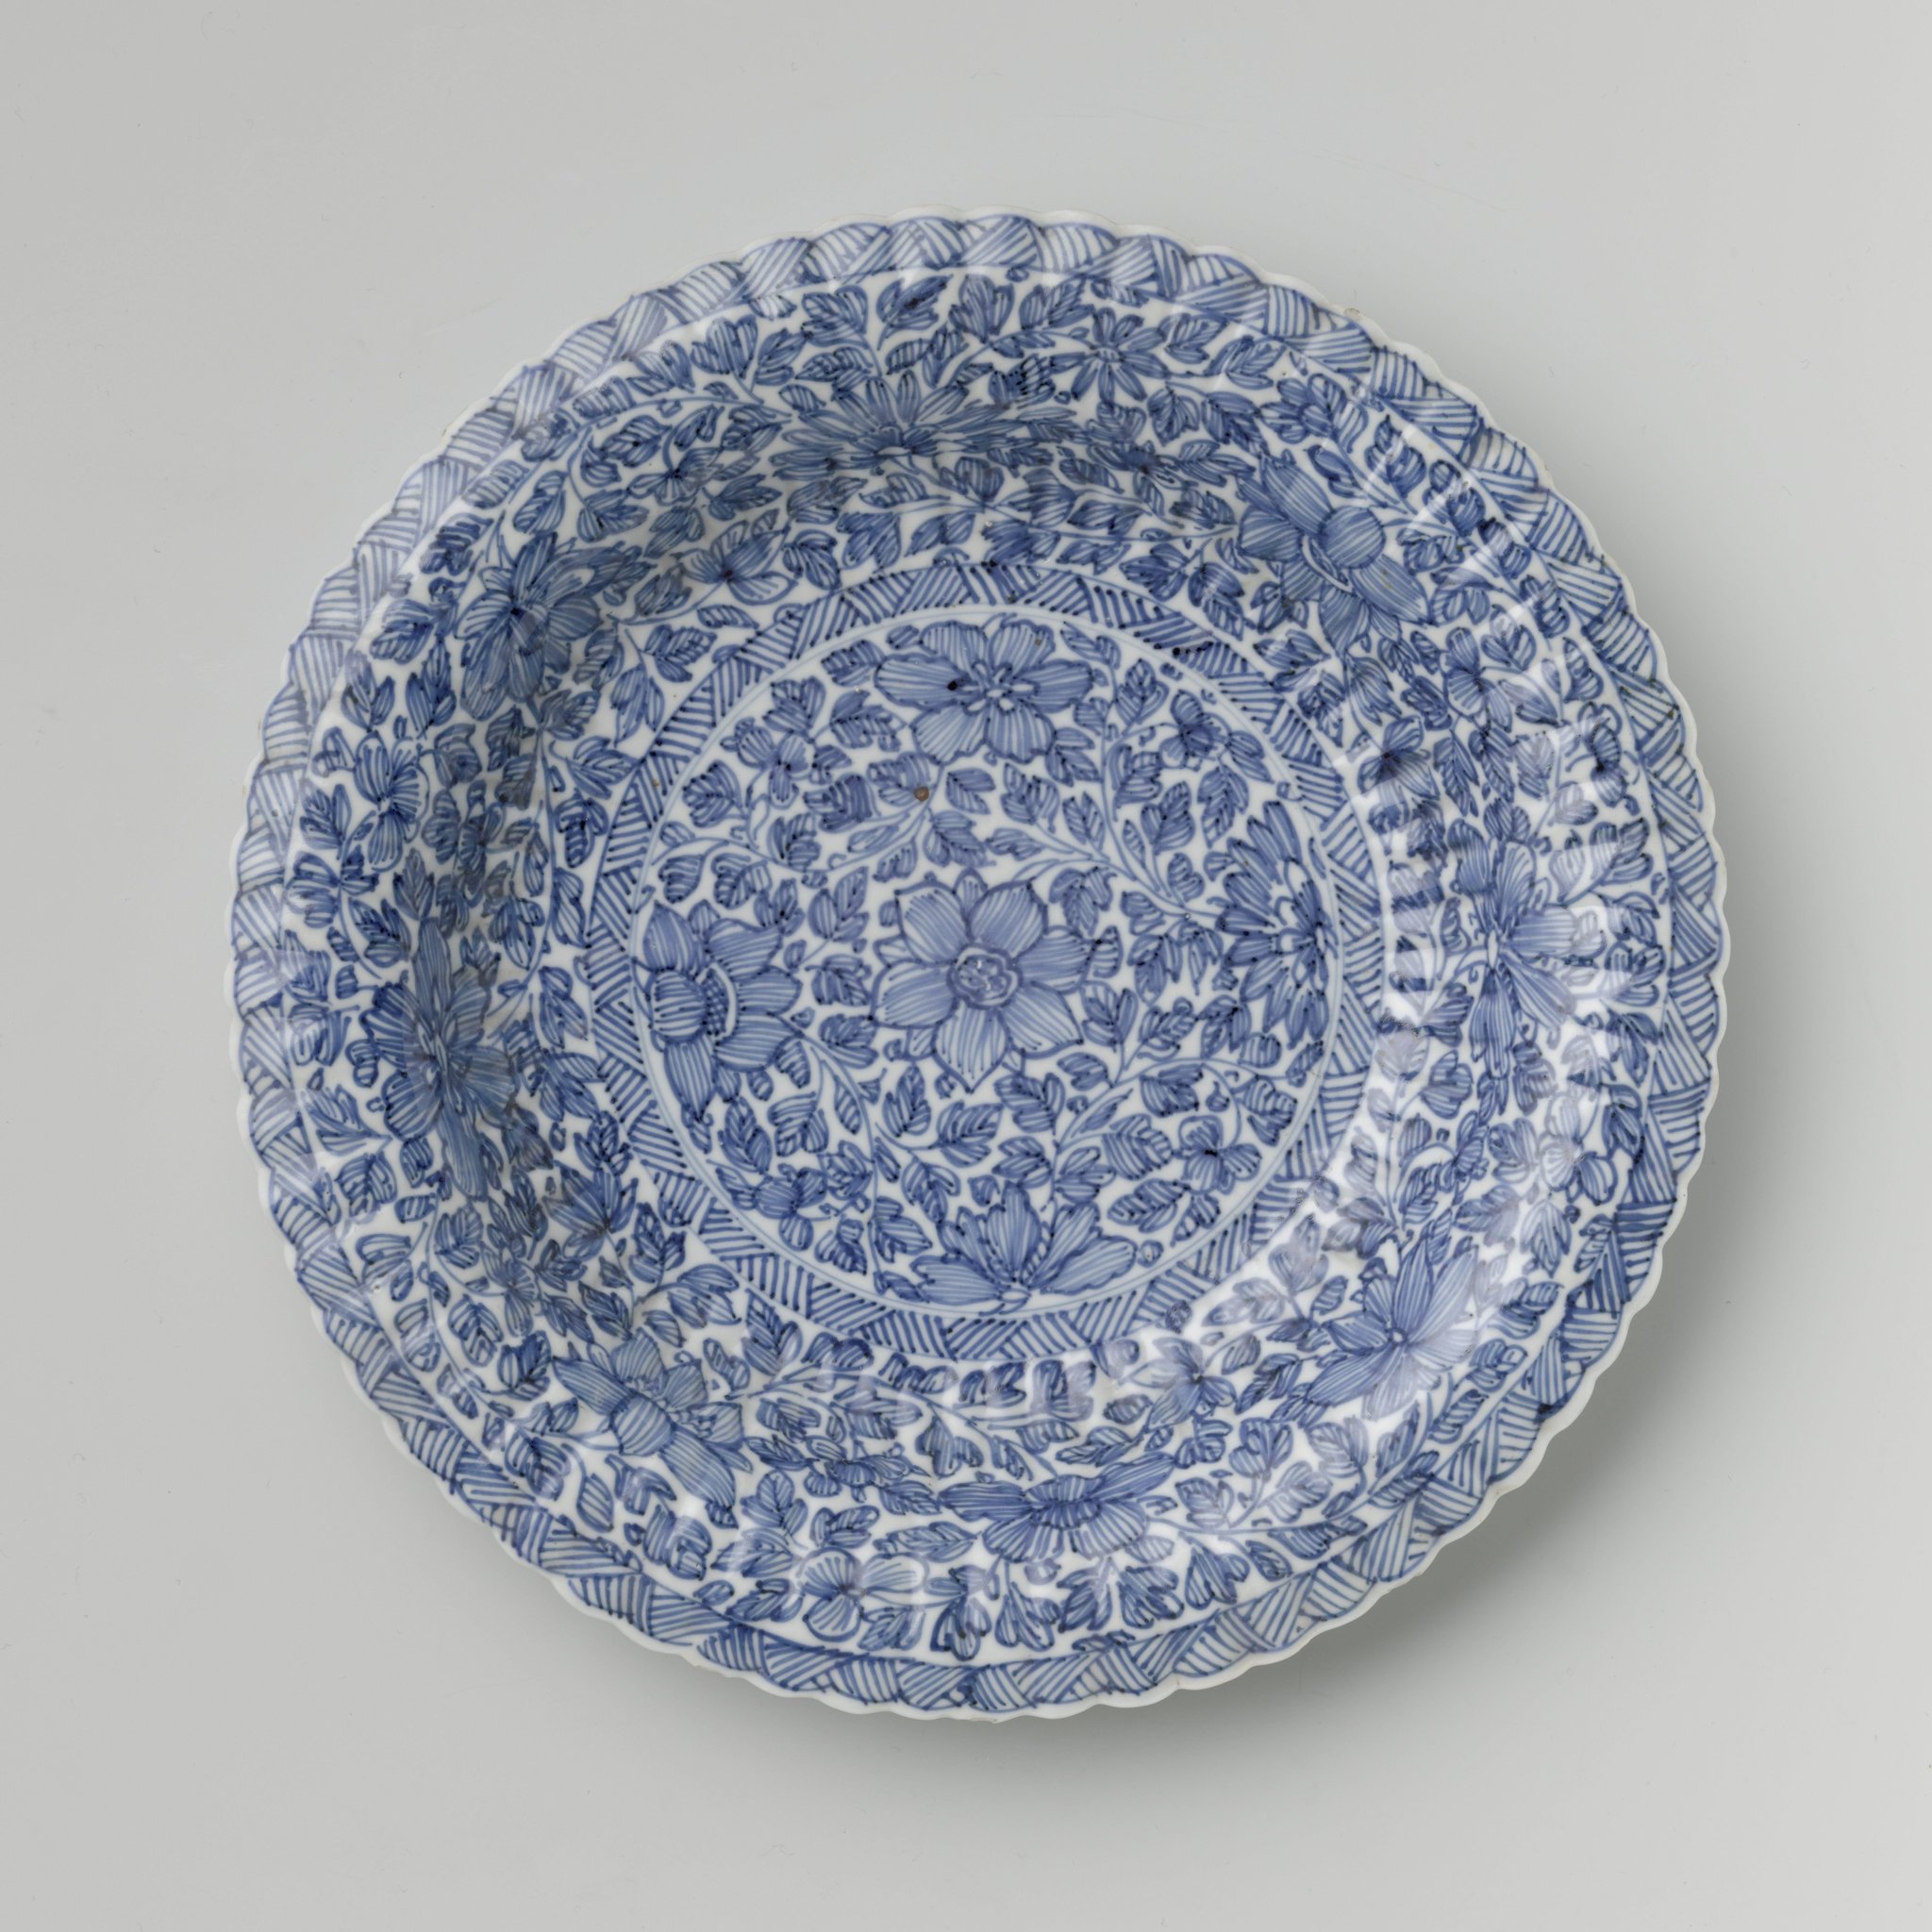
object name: plate dish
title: Plate with fluted sides and continuous flower pattern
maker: Anonymous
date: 1700-1724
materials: cobalt, glaze, paint, porcelain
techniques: firing, forming, turning, vitrification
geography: china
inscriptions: mark